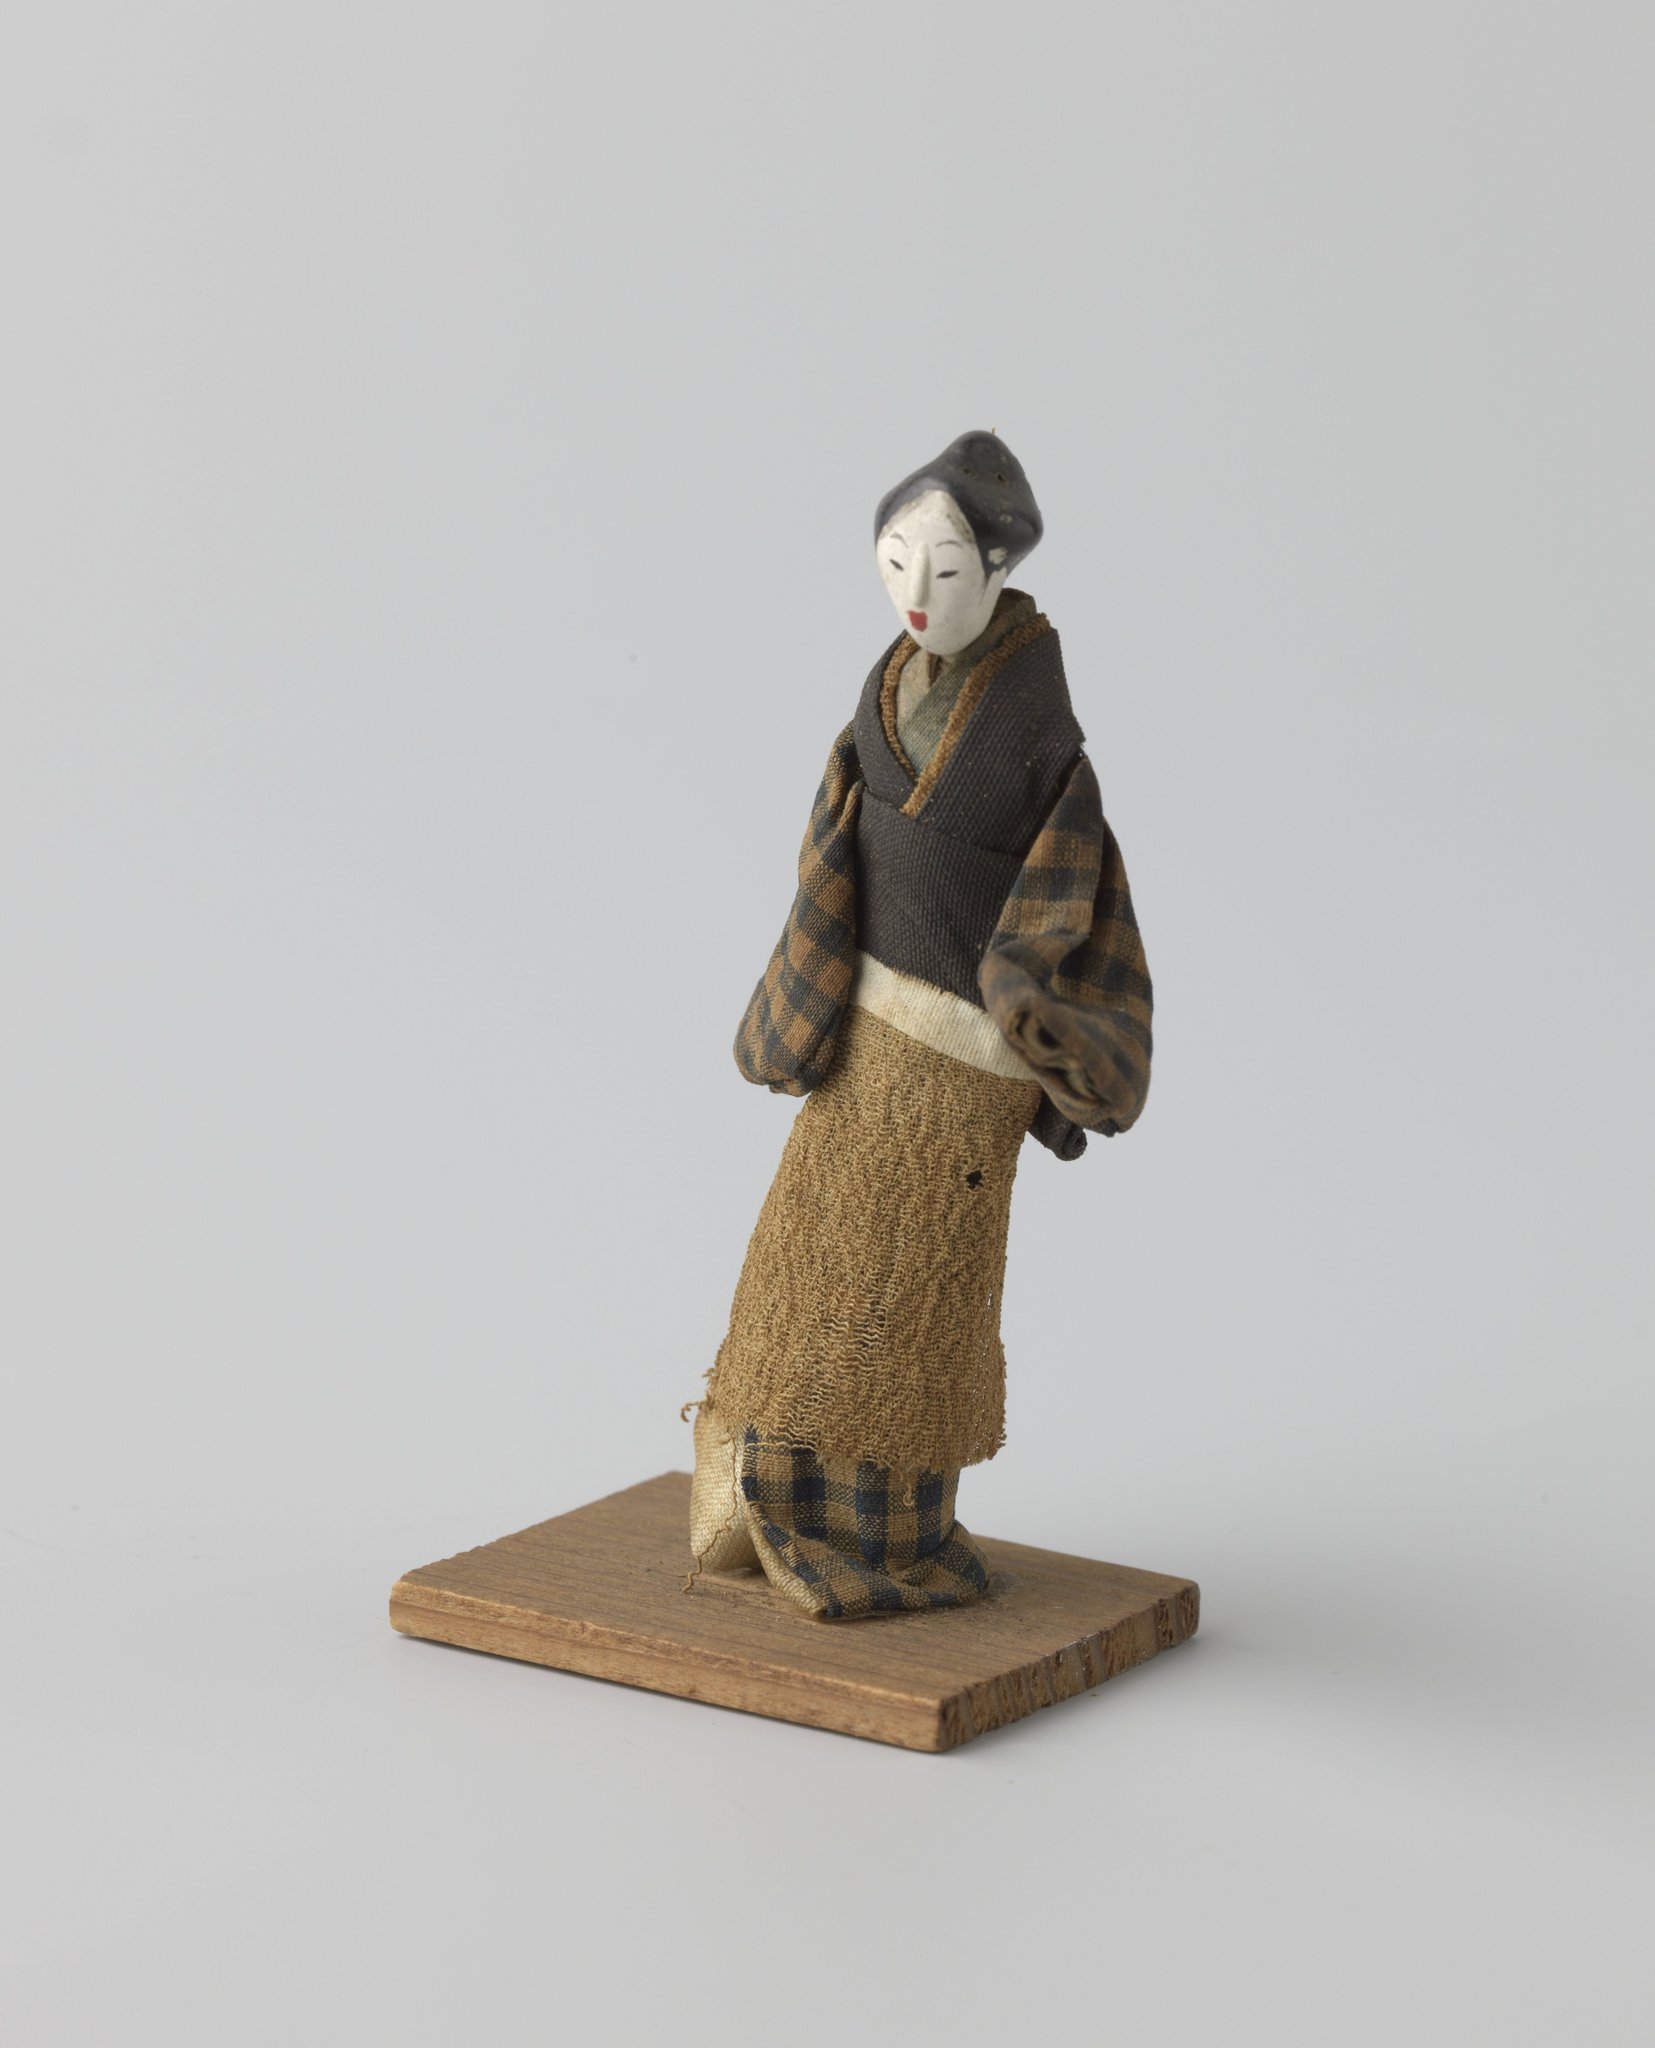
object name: doll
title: Poppetje van hout in Japanse kleding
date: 1900-2000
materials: wood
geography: japan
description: Poppetje van hout in Japanse kleding op een houten plankje bevestigd.